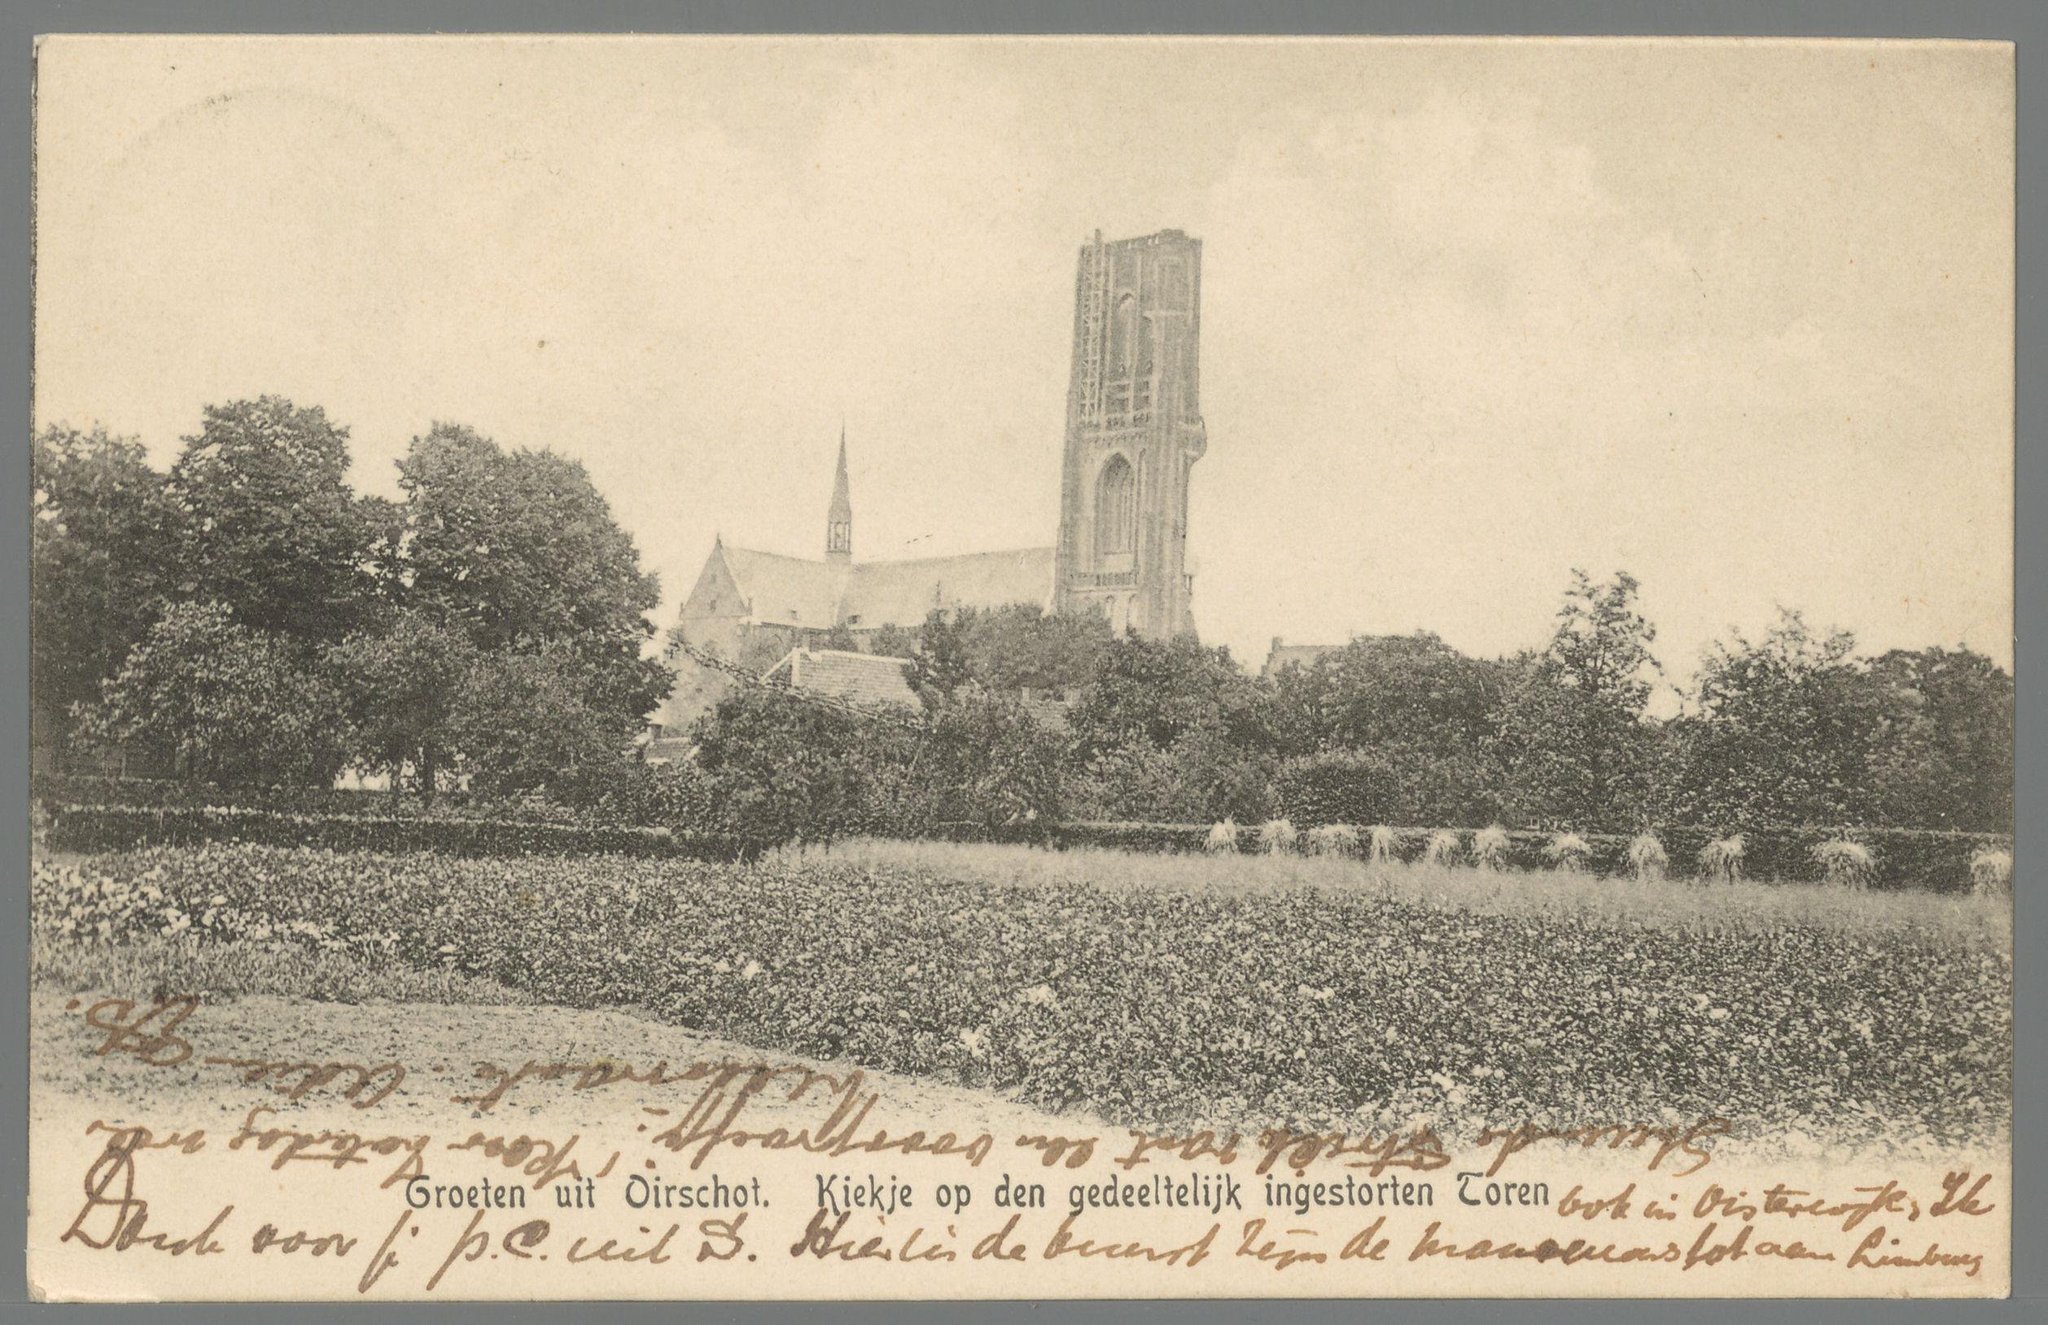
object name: photomechanical print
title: Groeten uit Oirschot. Kiekje op den gedeeltelijk ingestorten toren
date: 1904-1905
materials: cardboard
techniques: photograph, writing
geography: waalre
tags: church (exterior)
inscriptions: postage stamp